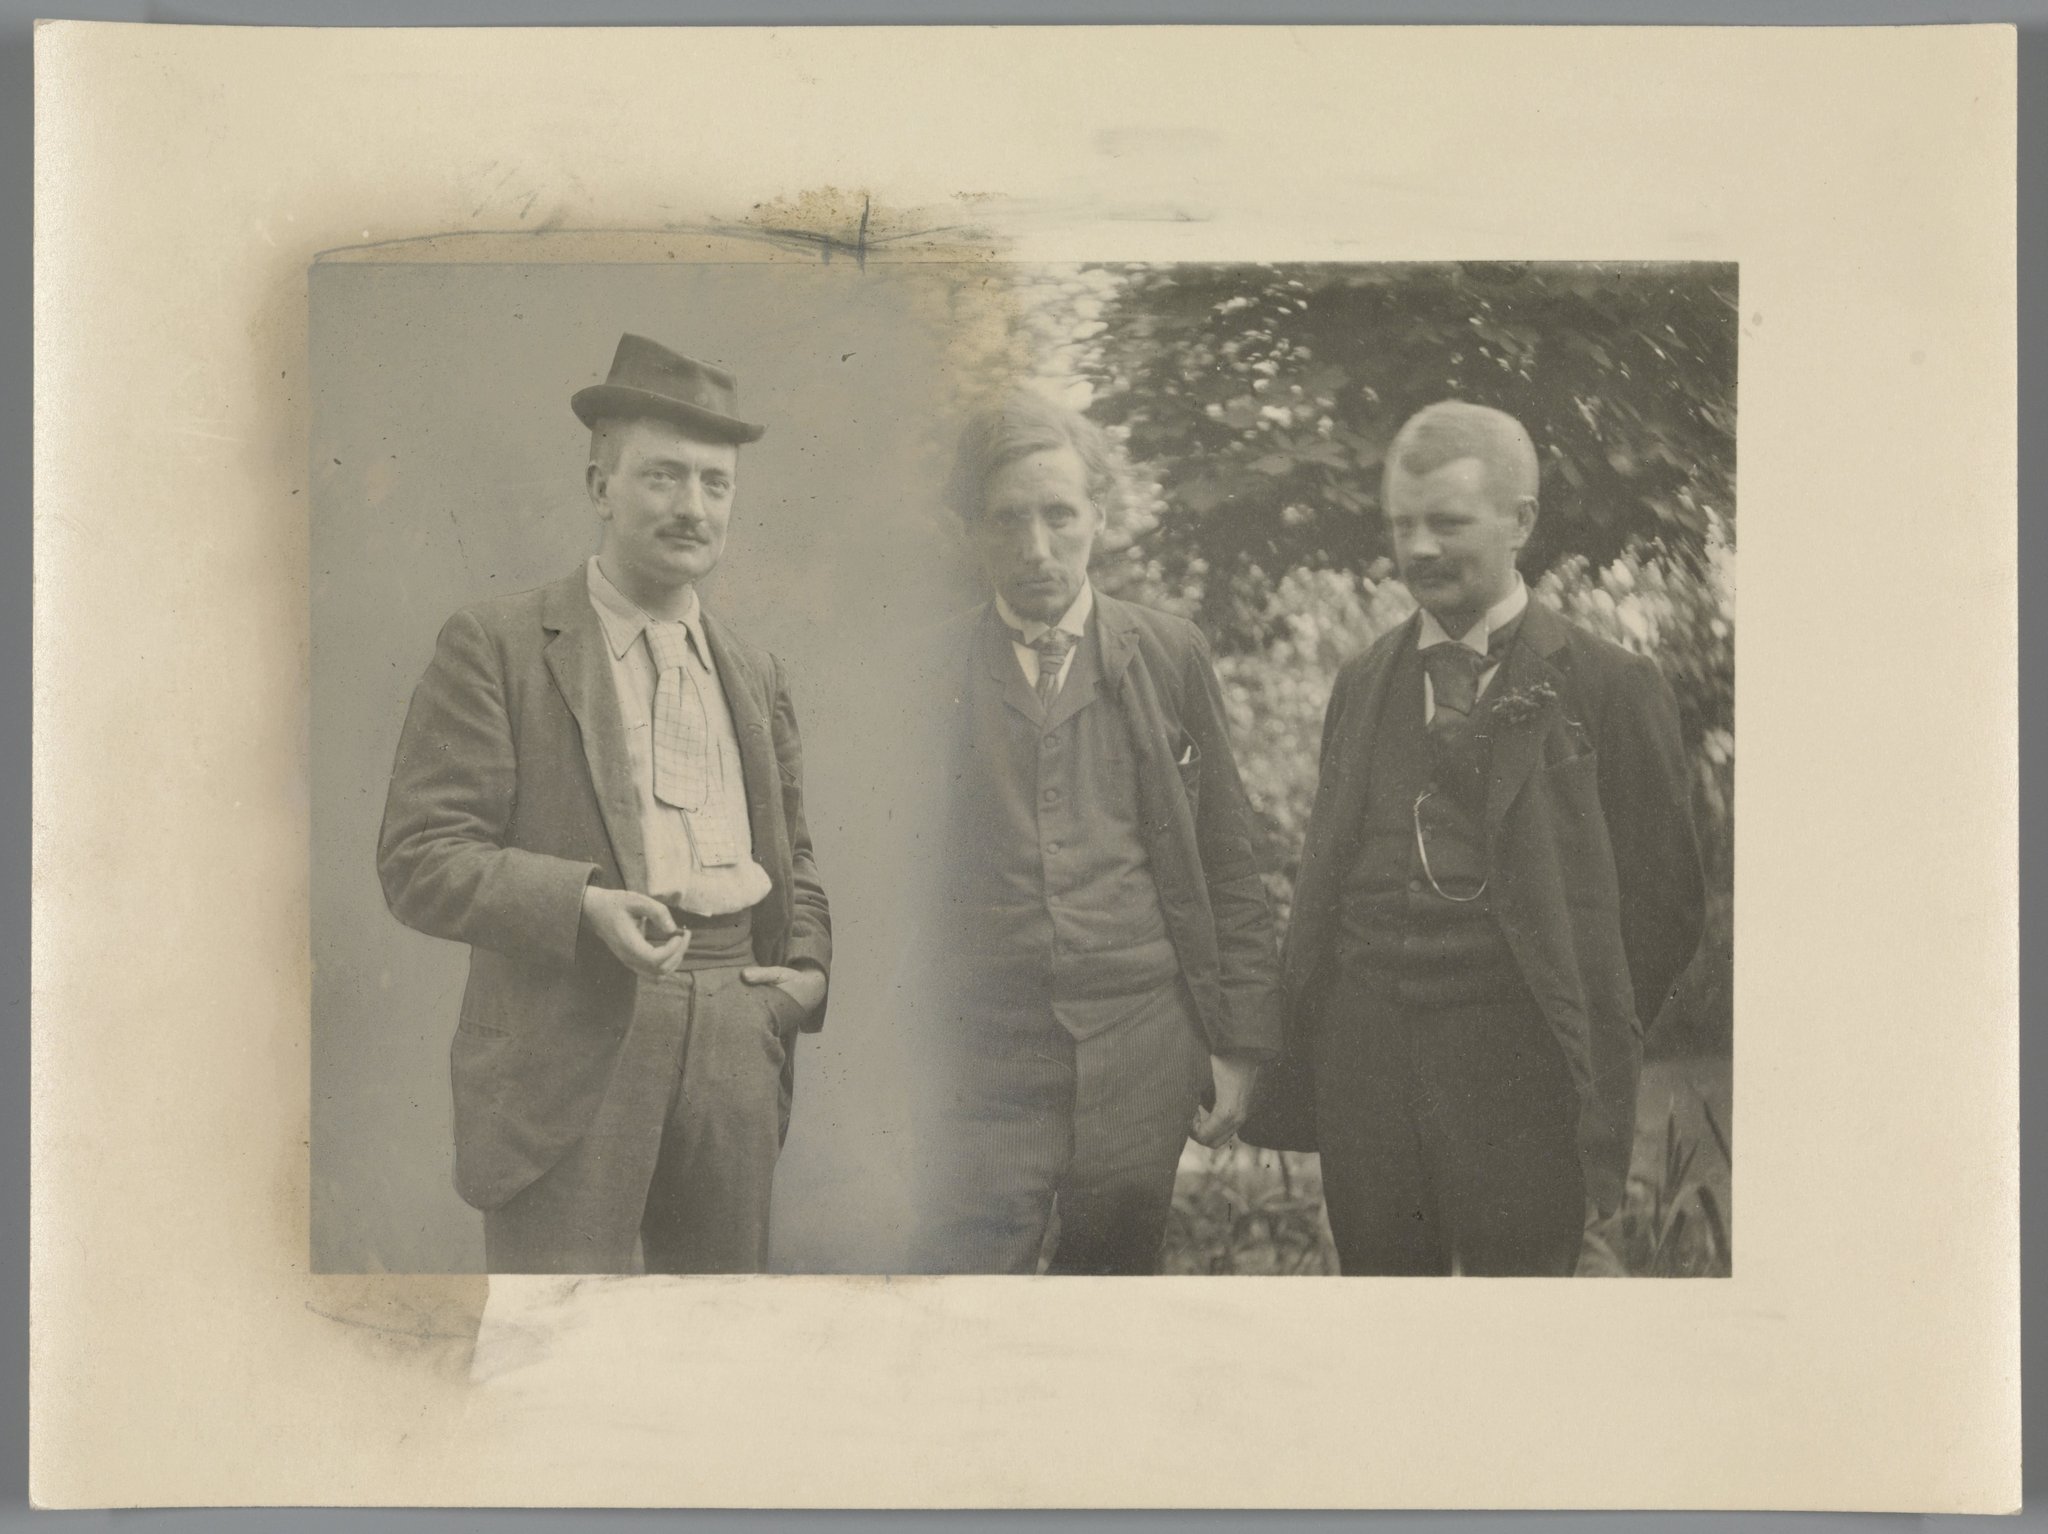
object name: photograph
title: Reproductie naar een foto van Willem Witsen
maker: Anonymous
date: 1860-1915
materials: paper, photographic support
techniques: gelatin silver print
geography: netherlands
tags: amsterdam, willem kloos